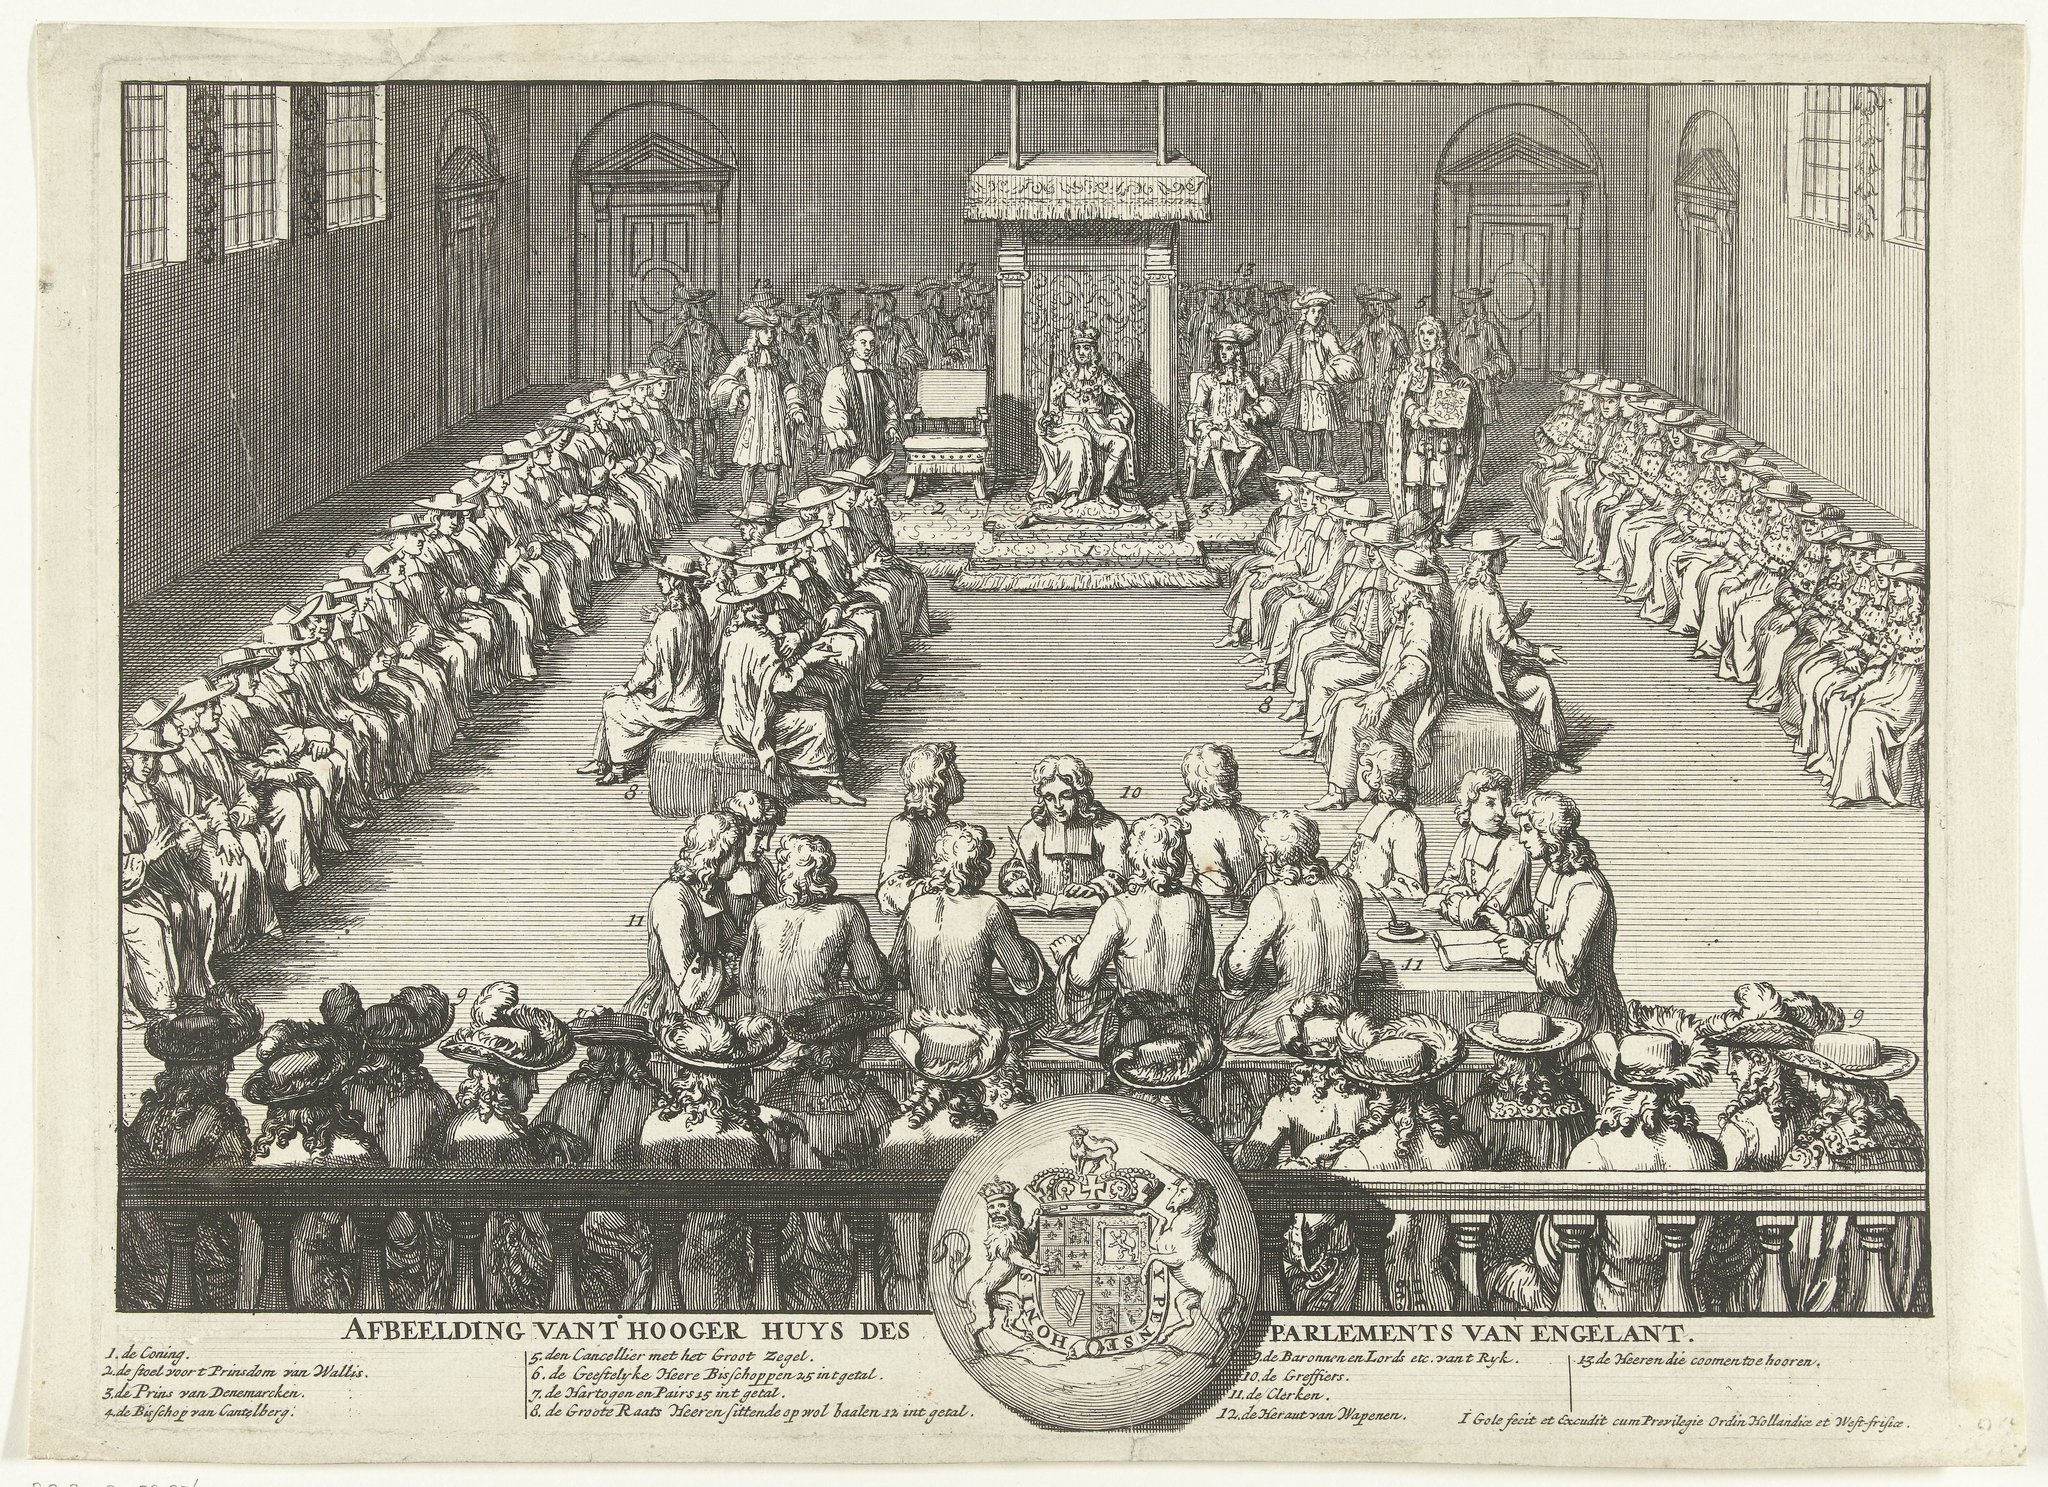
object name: print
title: Afbeelding van t Hooger huys des parlements van Engelant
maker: jacob gole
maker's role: print maker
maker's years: 1660-1724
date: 1689-1690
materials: paper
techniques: engraving, etching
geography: northern netherlands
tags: william iii (prince of orange and king of england, scotland, and ireland), upper house, senate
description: Een zitting van het Hogerhuis wordt door een koning bijgewoond. Centraal de koning op zijn troon, omgeven door de Lords, zittend op kussens. Vooraan de griffiers rond een tafel. In het onderschrift de legenda 1-13 en het Britse koninklijke wapen. De voorstelling is gebaseerd op een voorstelling waarin koning Willem III de vergadering bijwoont, 1689.